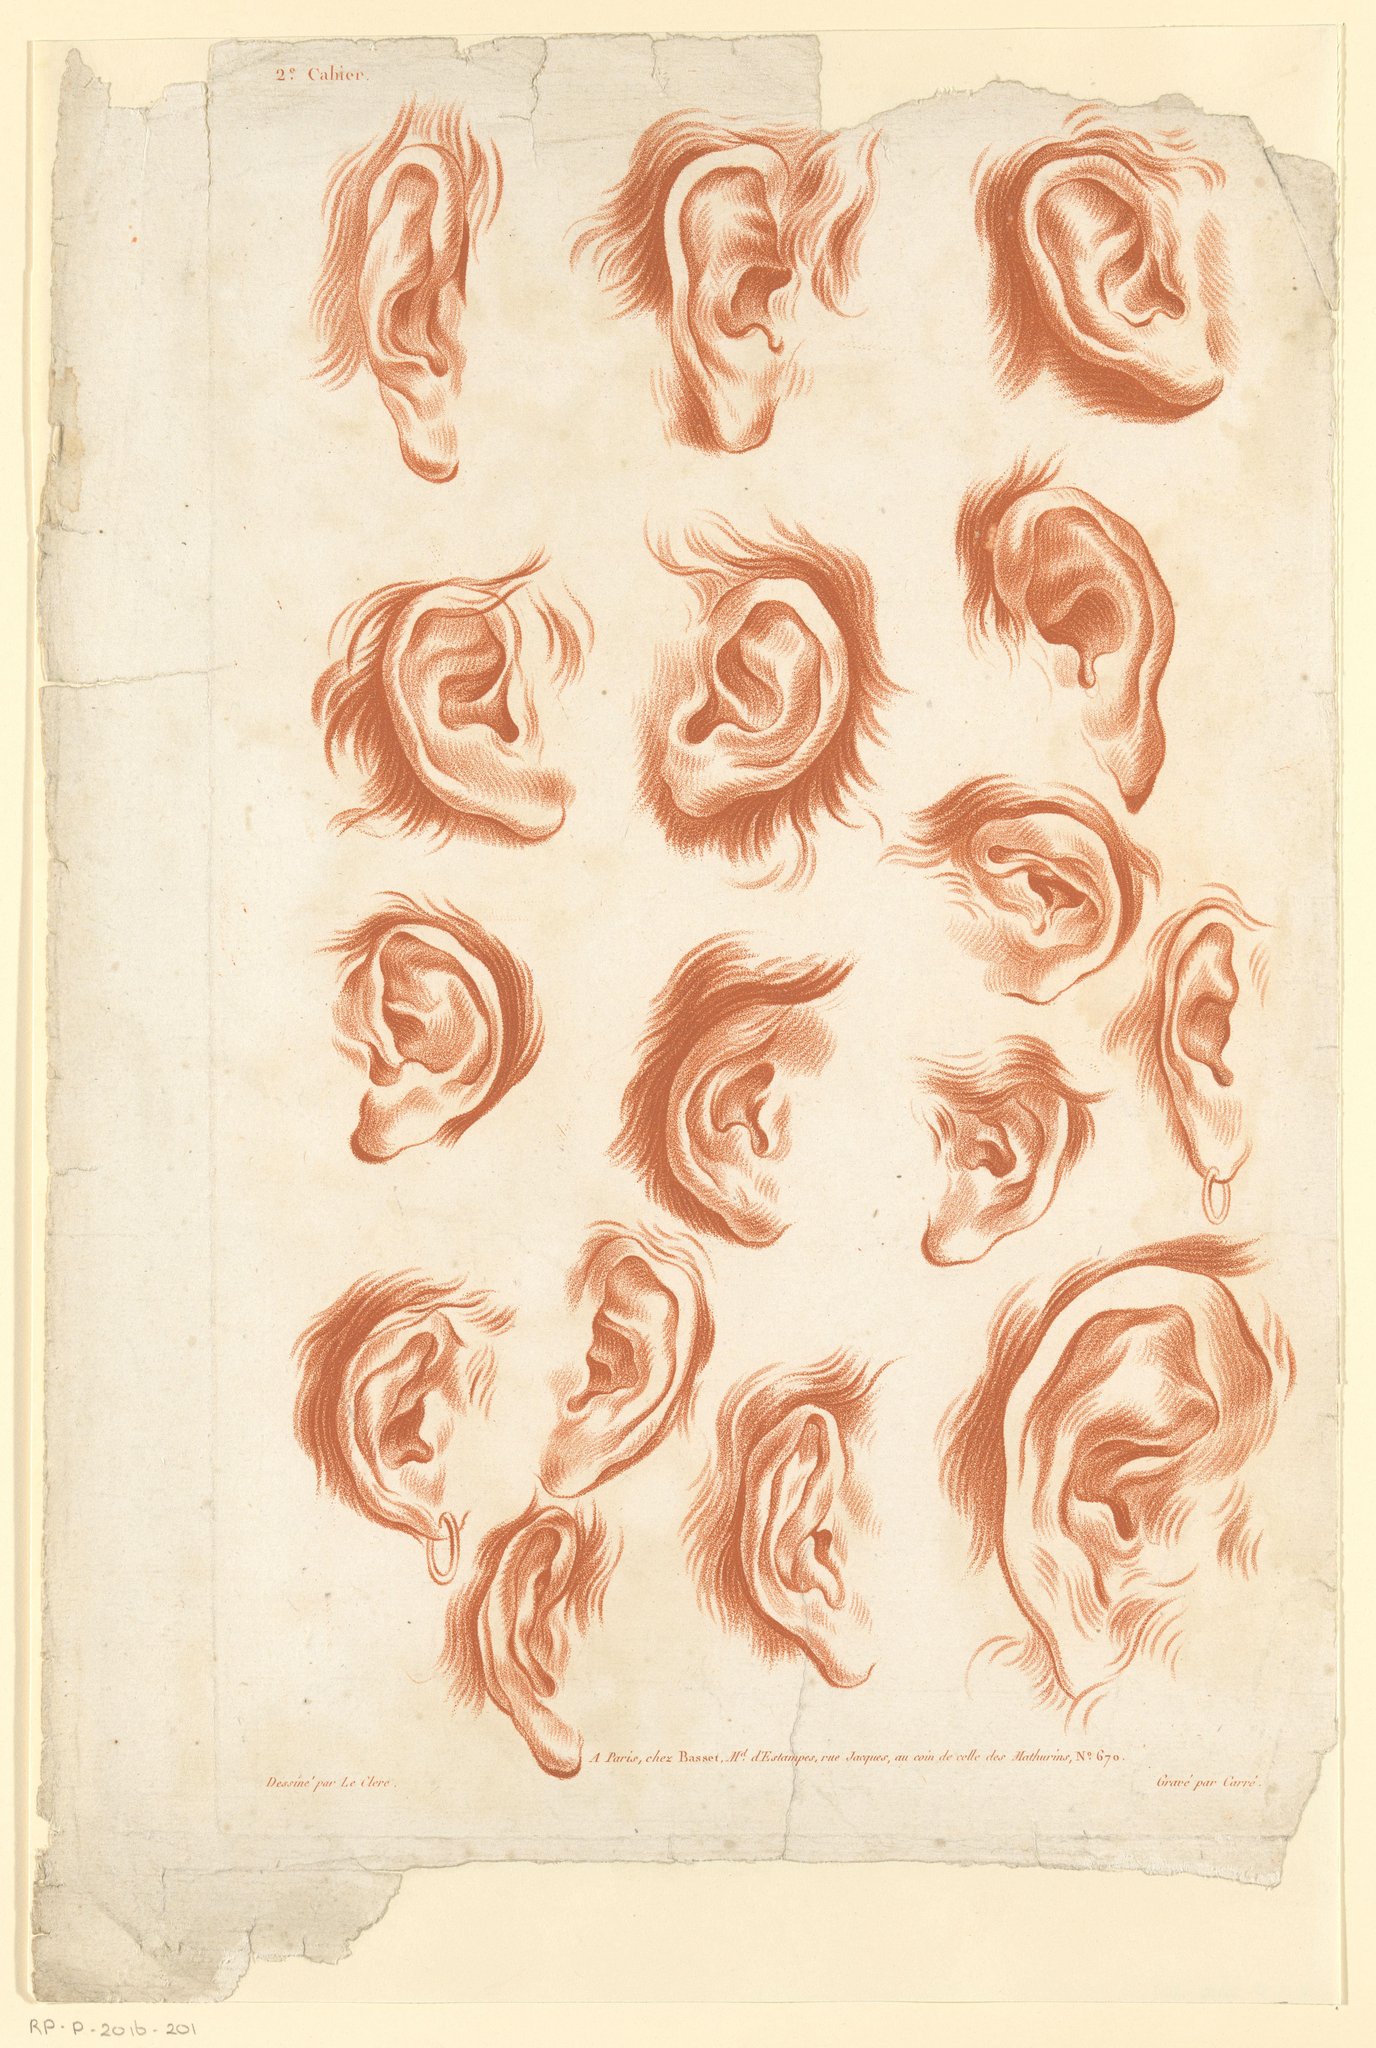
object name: tekenvoorbeeld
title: 2e Cahier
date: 1795-1819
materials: paper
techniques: printmaking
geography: paris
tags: drawing, sketch, ears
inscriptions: collector's mark: Lugt 2228